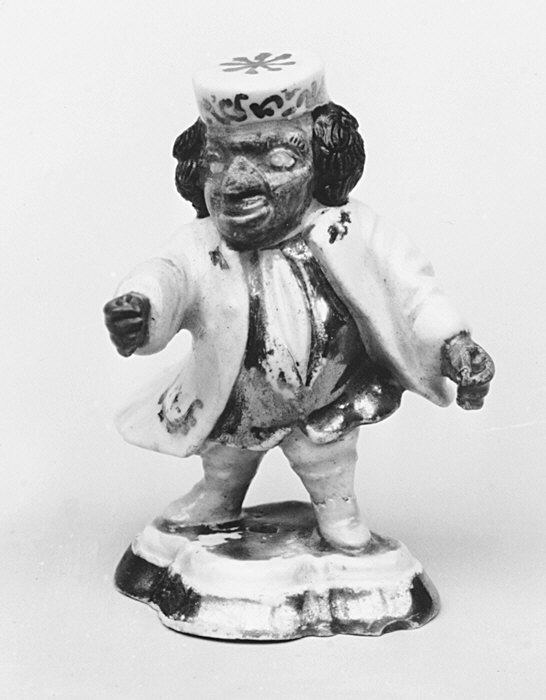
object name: figure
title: Male Callot dwarf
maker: meissen manufactory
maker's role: manufactory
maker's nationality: german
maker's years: 1710-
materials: hard paste porcelain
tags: men